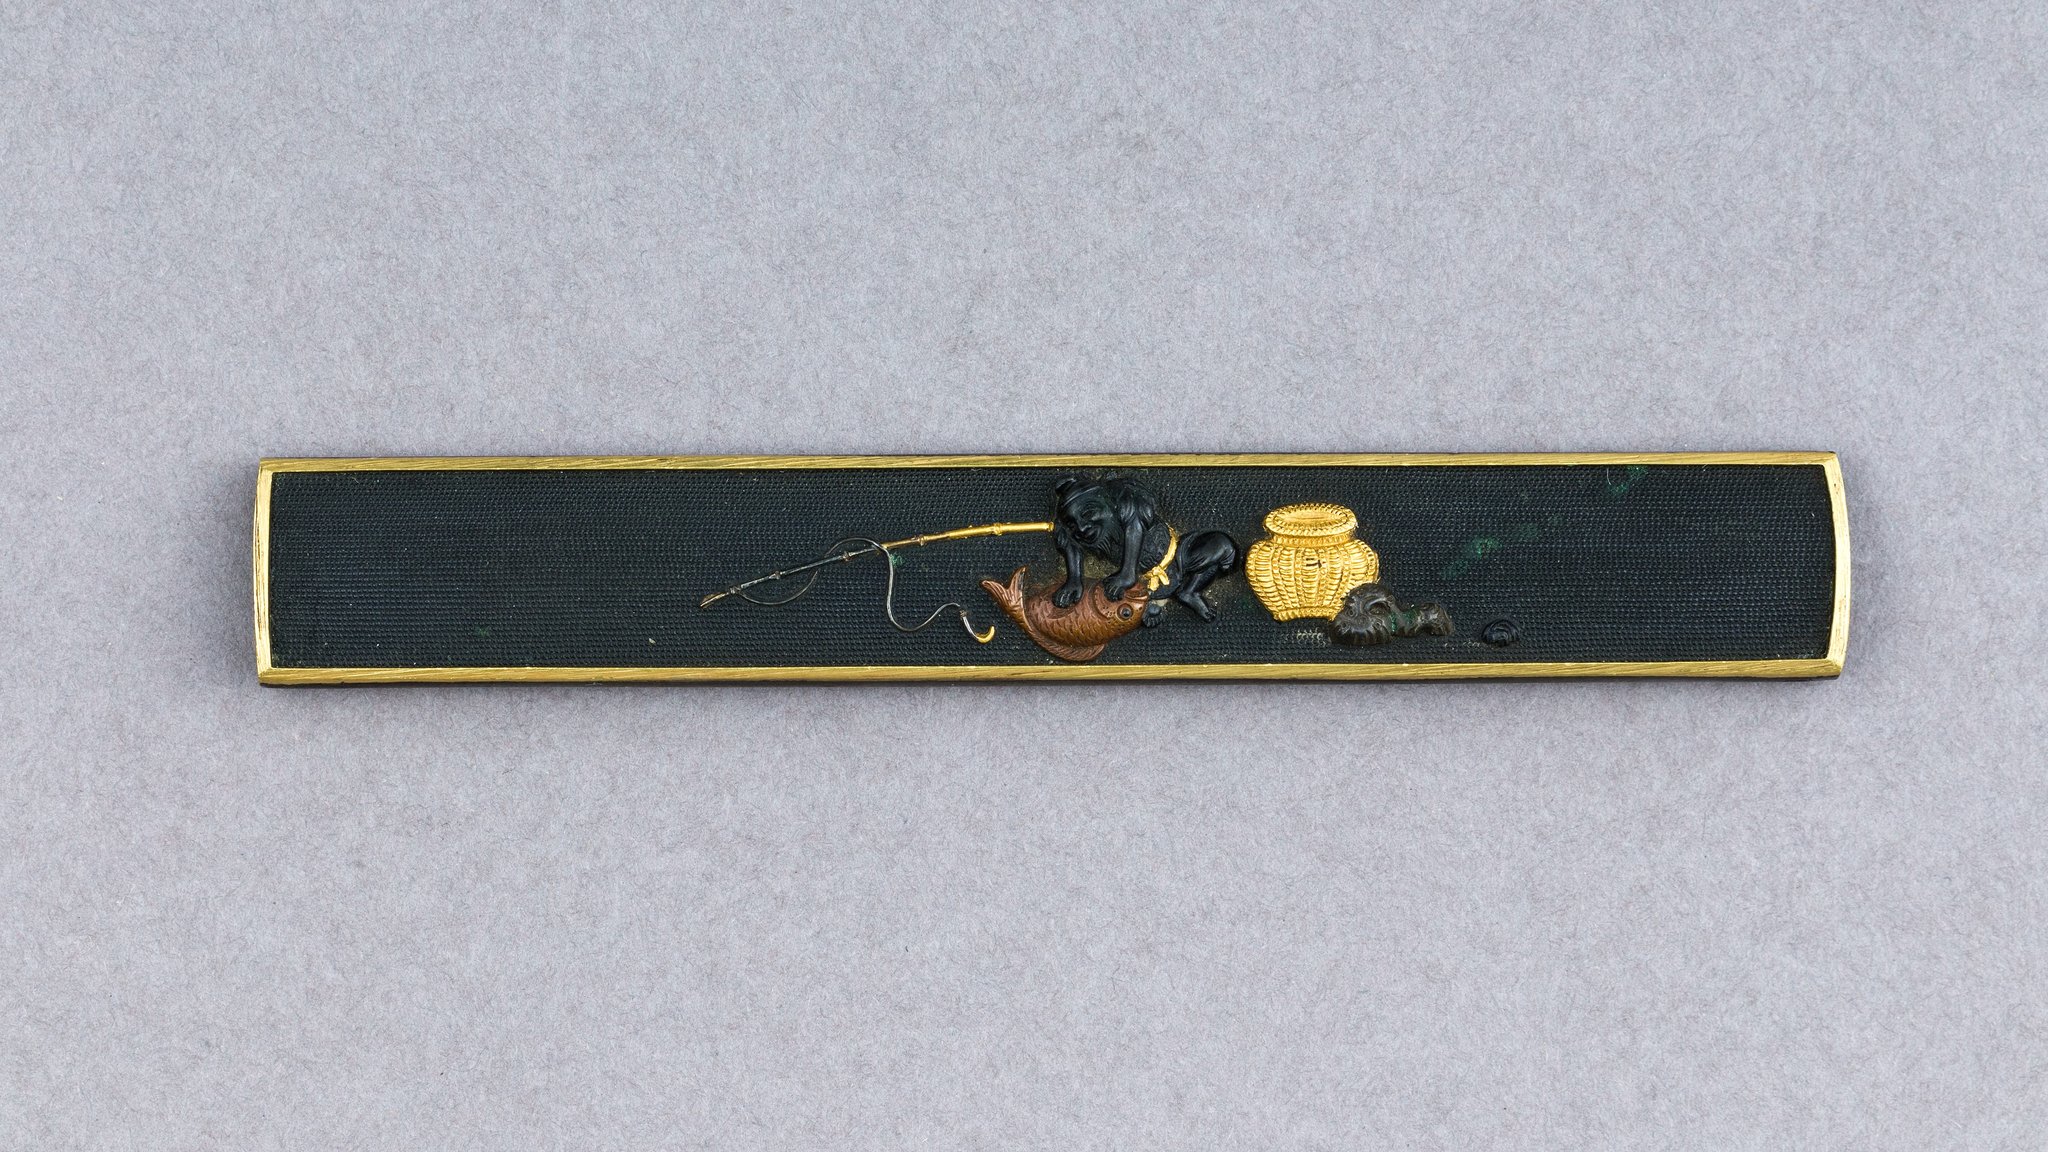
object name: knife handle kozuka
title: Knife Handle (Kozuka)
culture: japanese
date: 1615-1868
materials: copper, gold alloy, silver alloy, gold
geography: japan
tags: men,fish